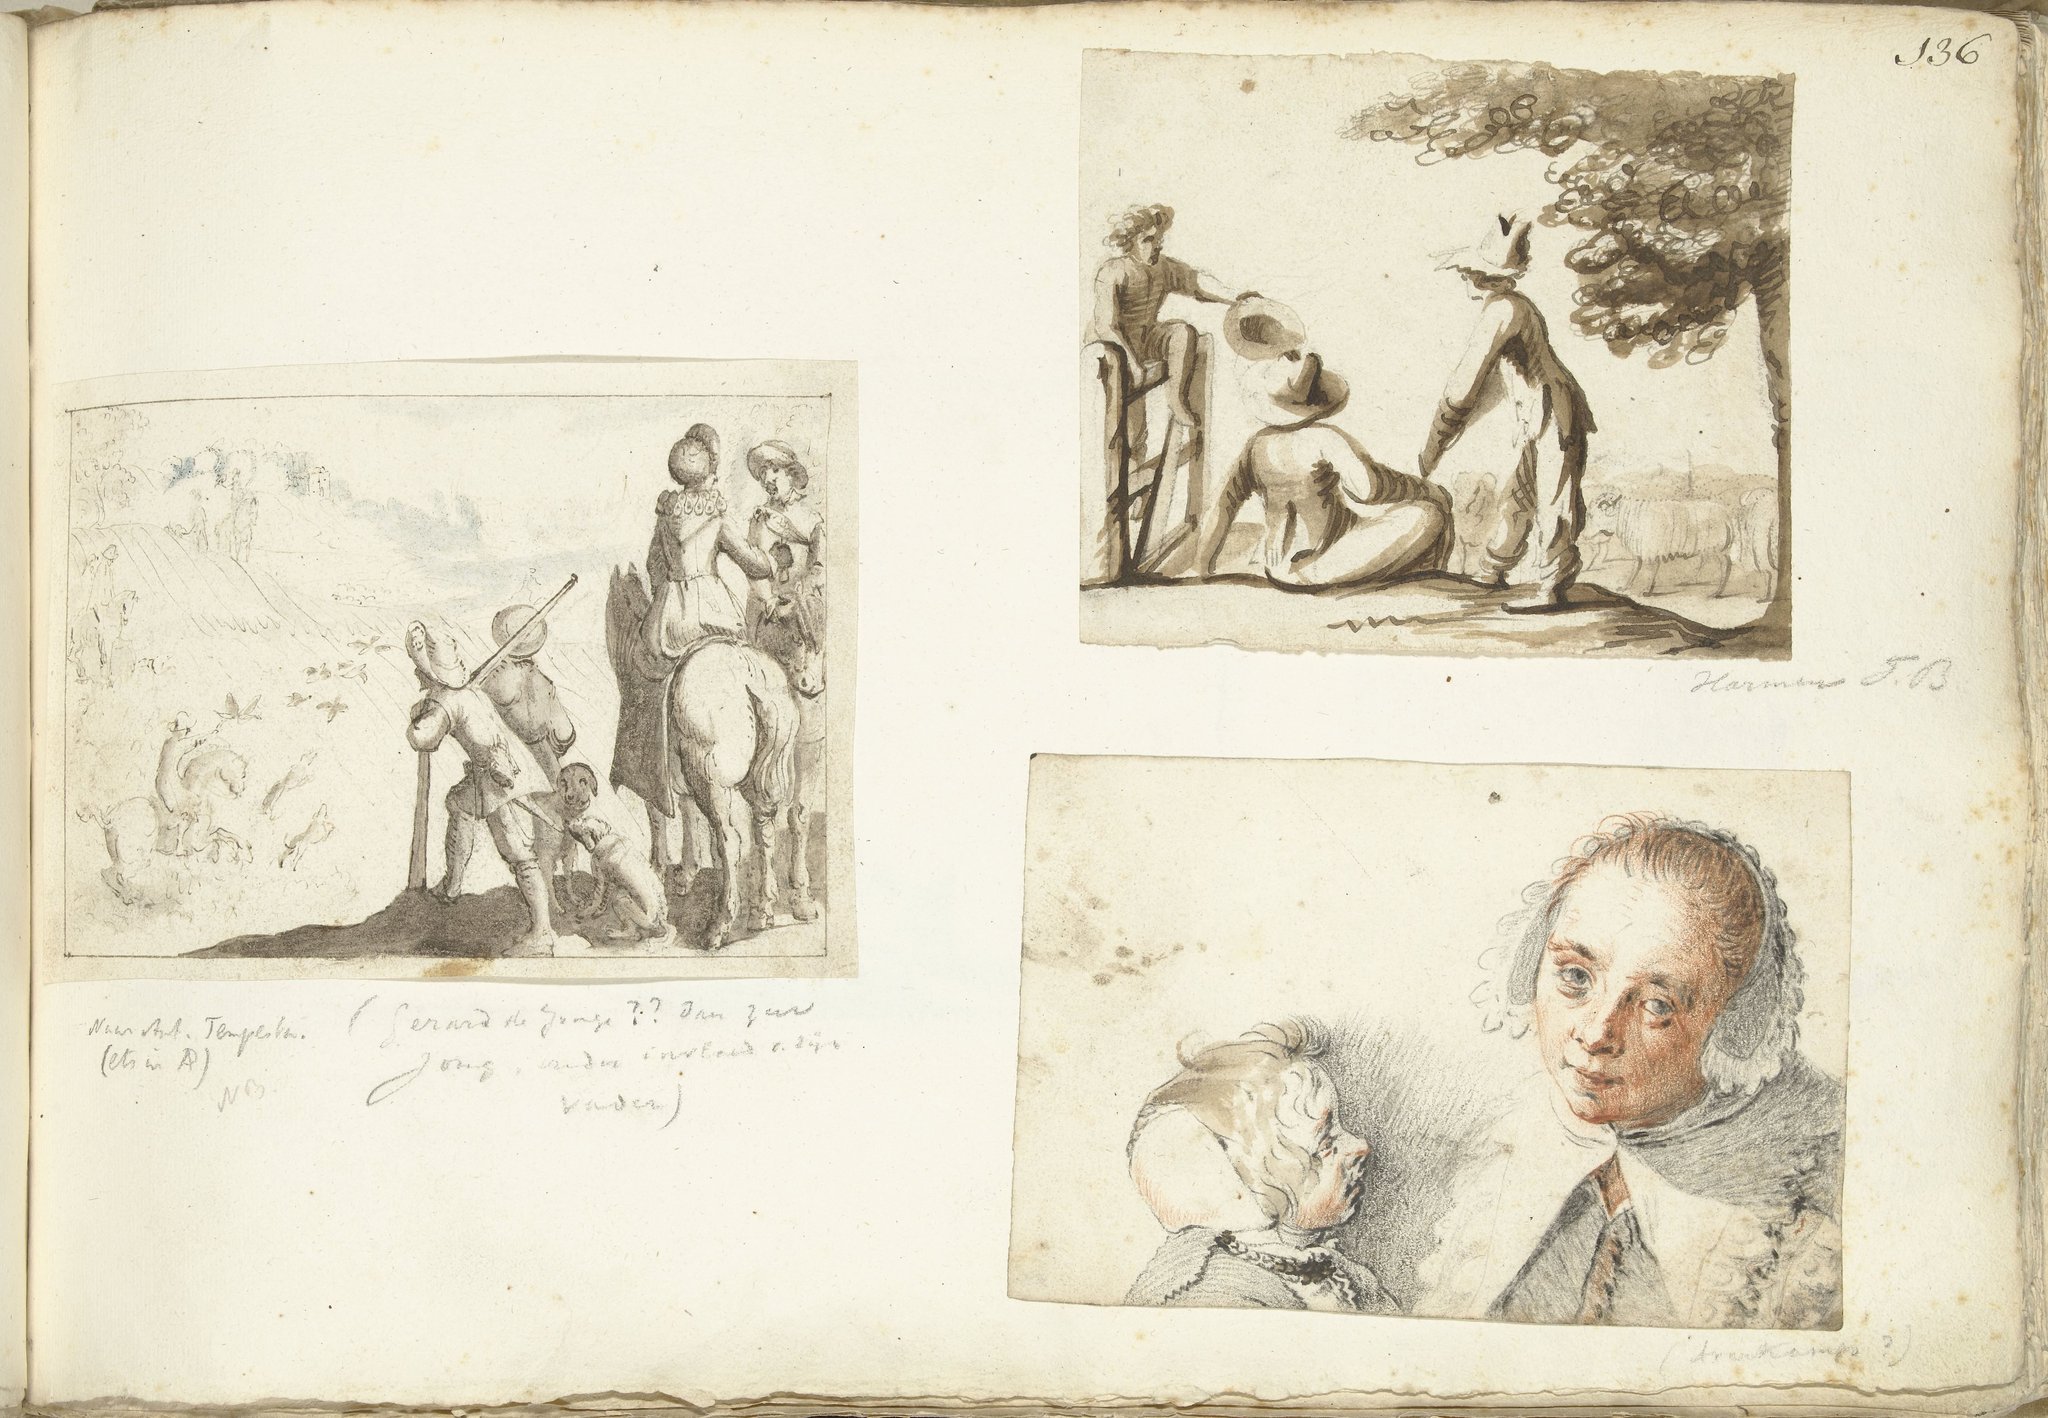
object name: watercolor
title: Jagers met valken, herderjongens en vrouw en kind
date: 1594-1681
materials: chalk, ink, paper, watercolor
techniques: brush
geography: netherlands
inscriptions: annotation: ‘Naar Ant. Tempesta/ (ets in AP) (Gerard de jonge?? dan zeer / jong, onder invloed v. zijn vader) / Harmen T.B. / (Averkamp?)’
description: Drie tekeningen naast elkaar op een blad geplakt.